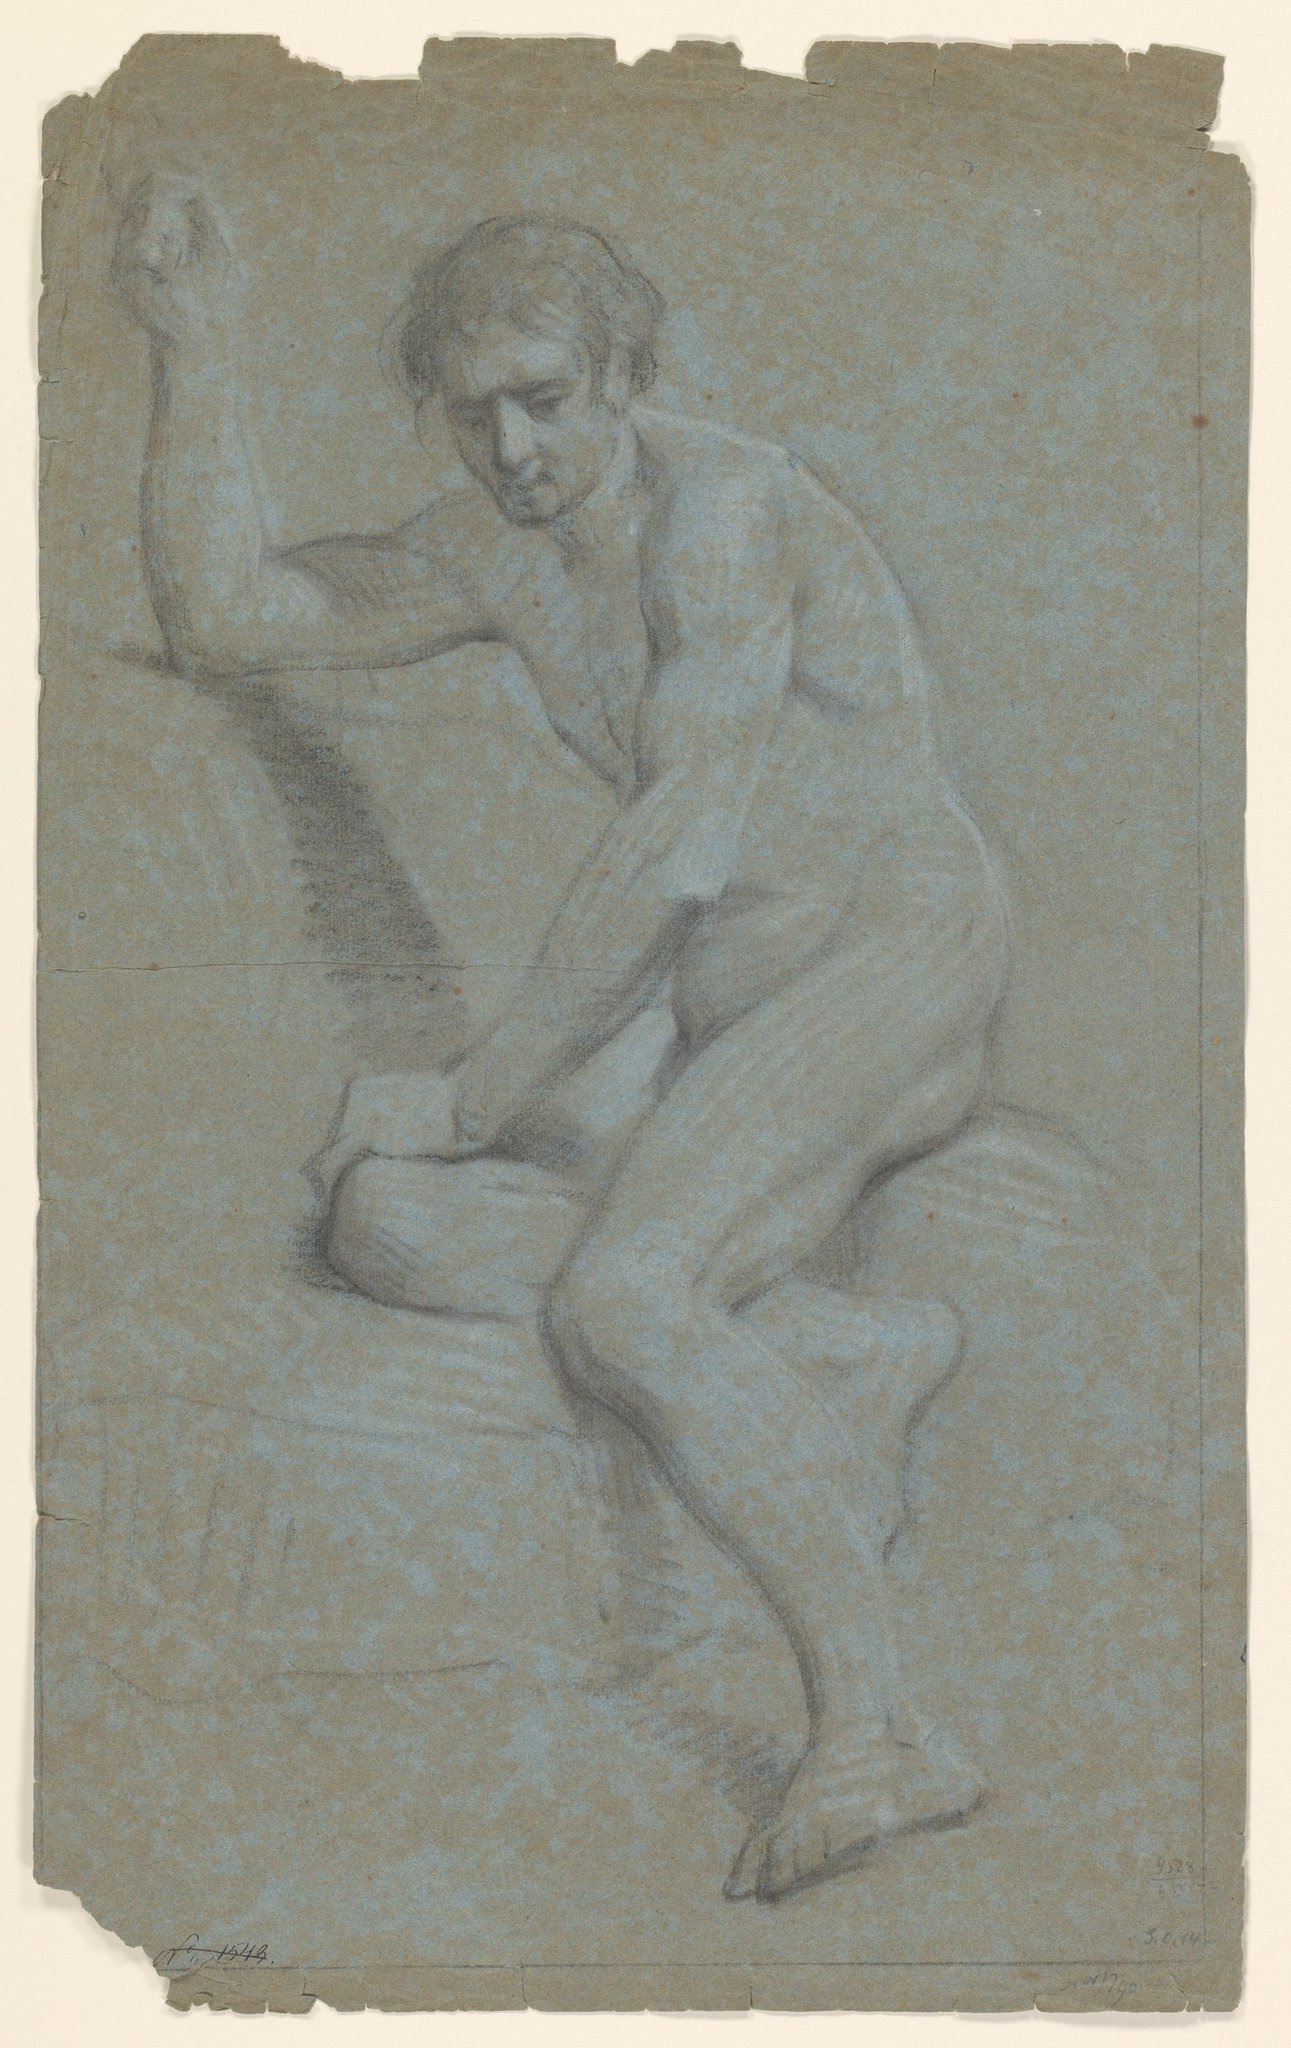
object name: drawing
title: Zittend mannelijk naakt, naar links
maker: Anonymous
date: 1796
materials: chalk, paper